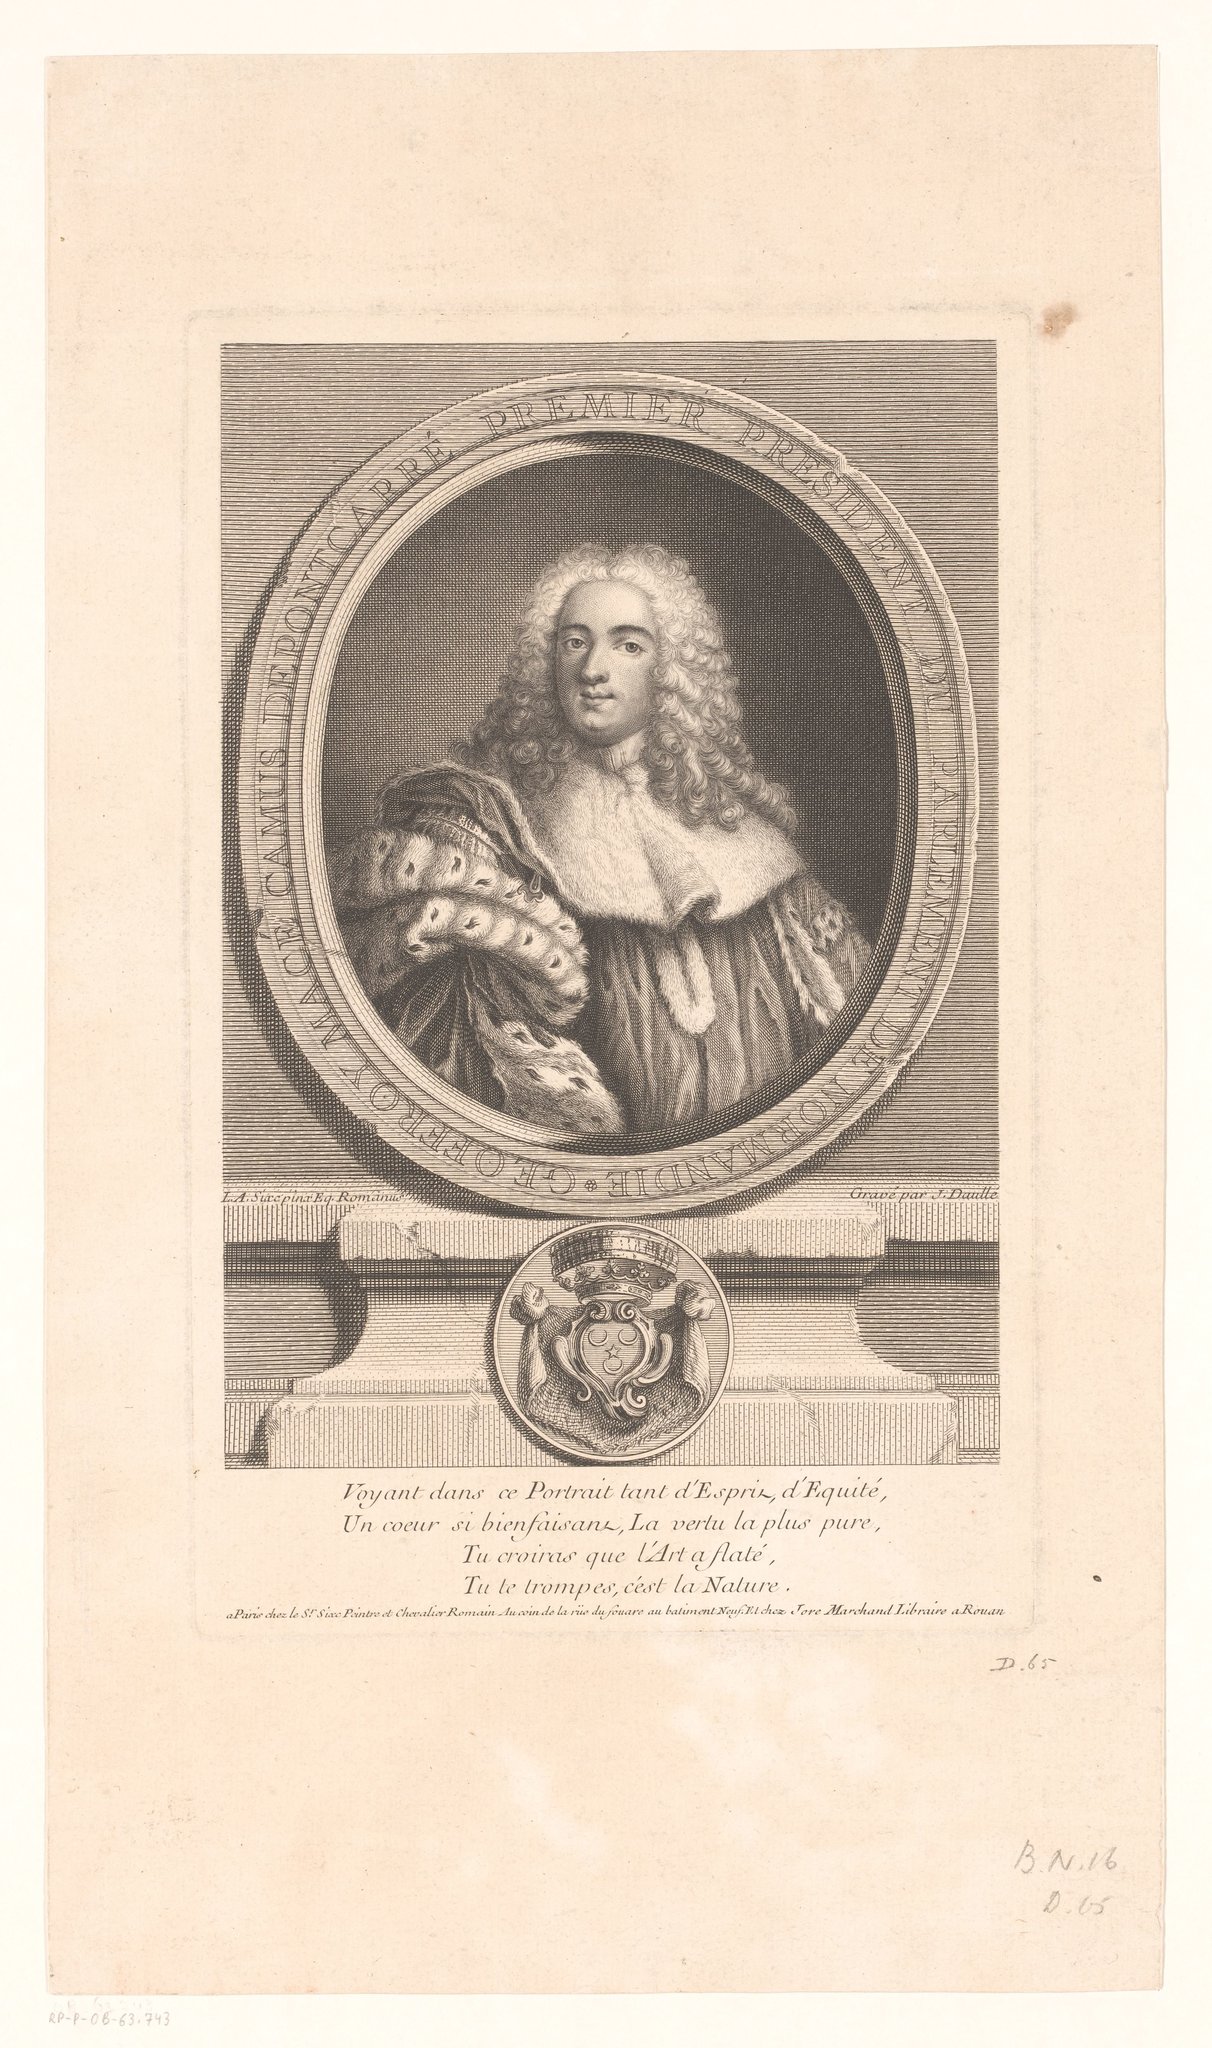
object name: print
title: Geoffroy Mace Camus Depontcarré premier president du parlement de Normandie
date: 1718-1763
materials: paper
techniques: etching, engraving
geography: france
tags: ornament ~ medallion, historical persons, armorial bearing, heraldry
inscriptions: collector's mark: Lugt 240